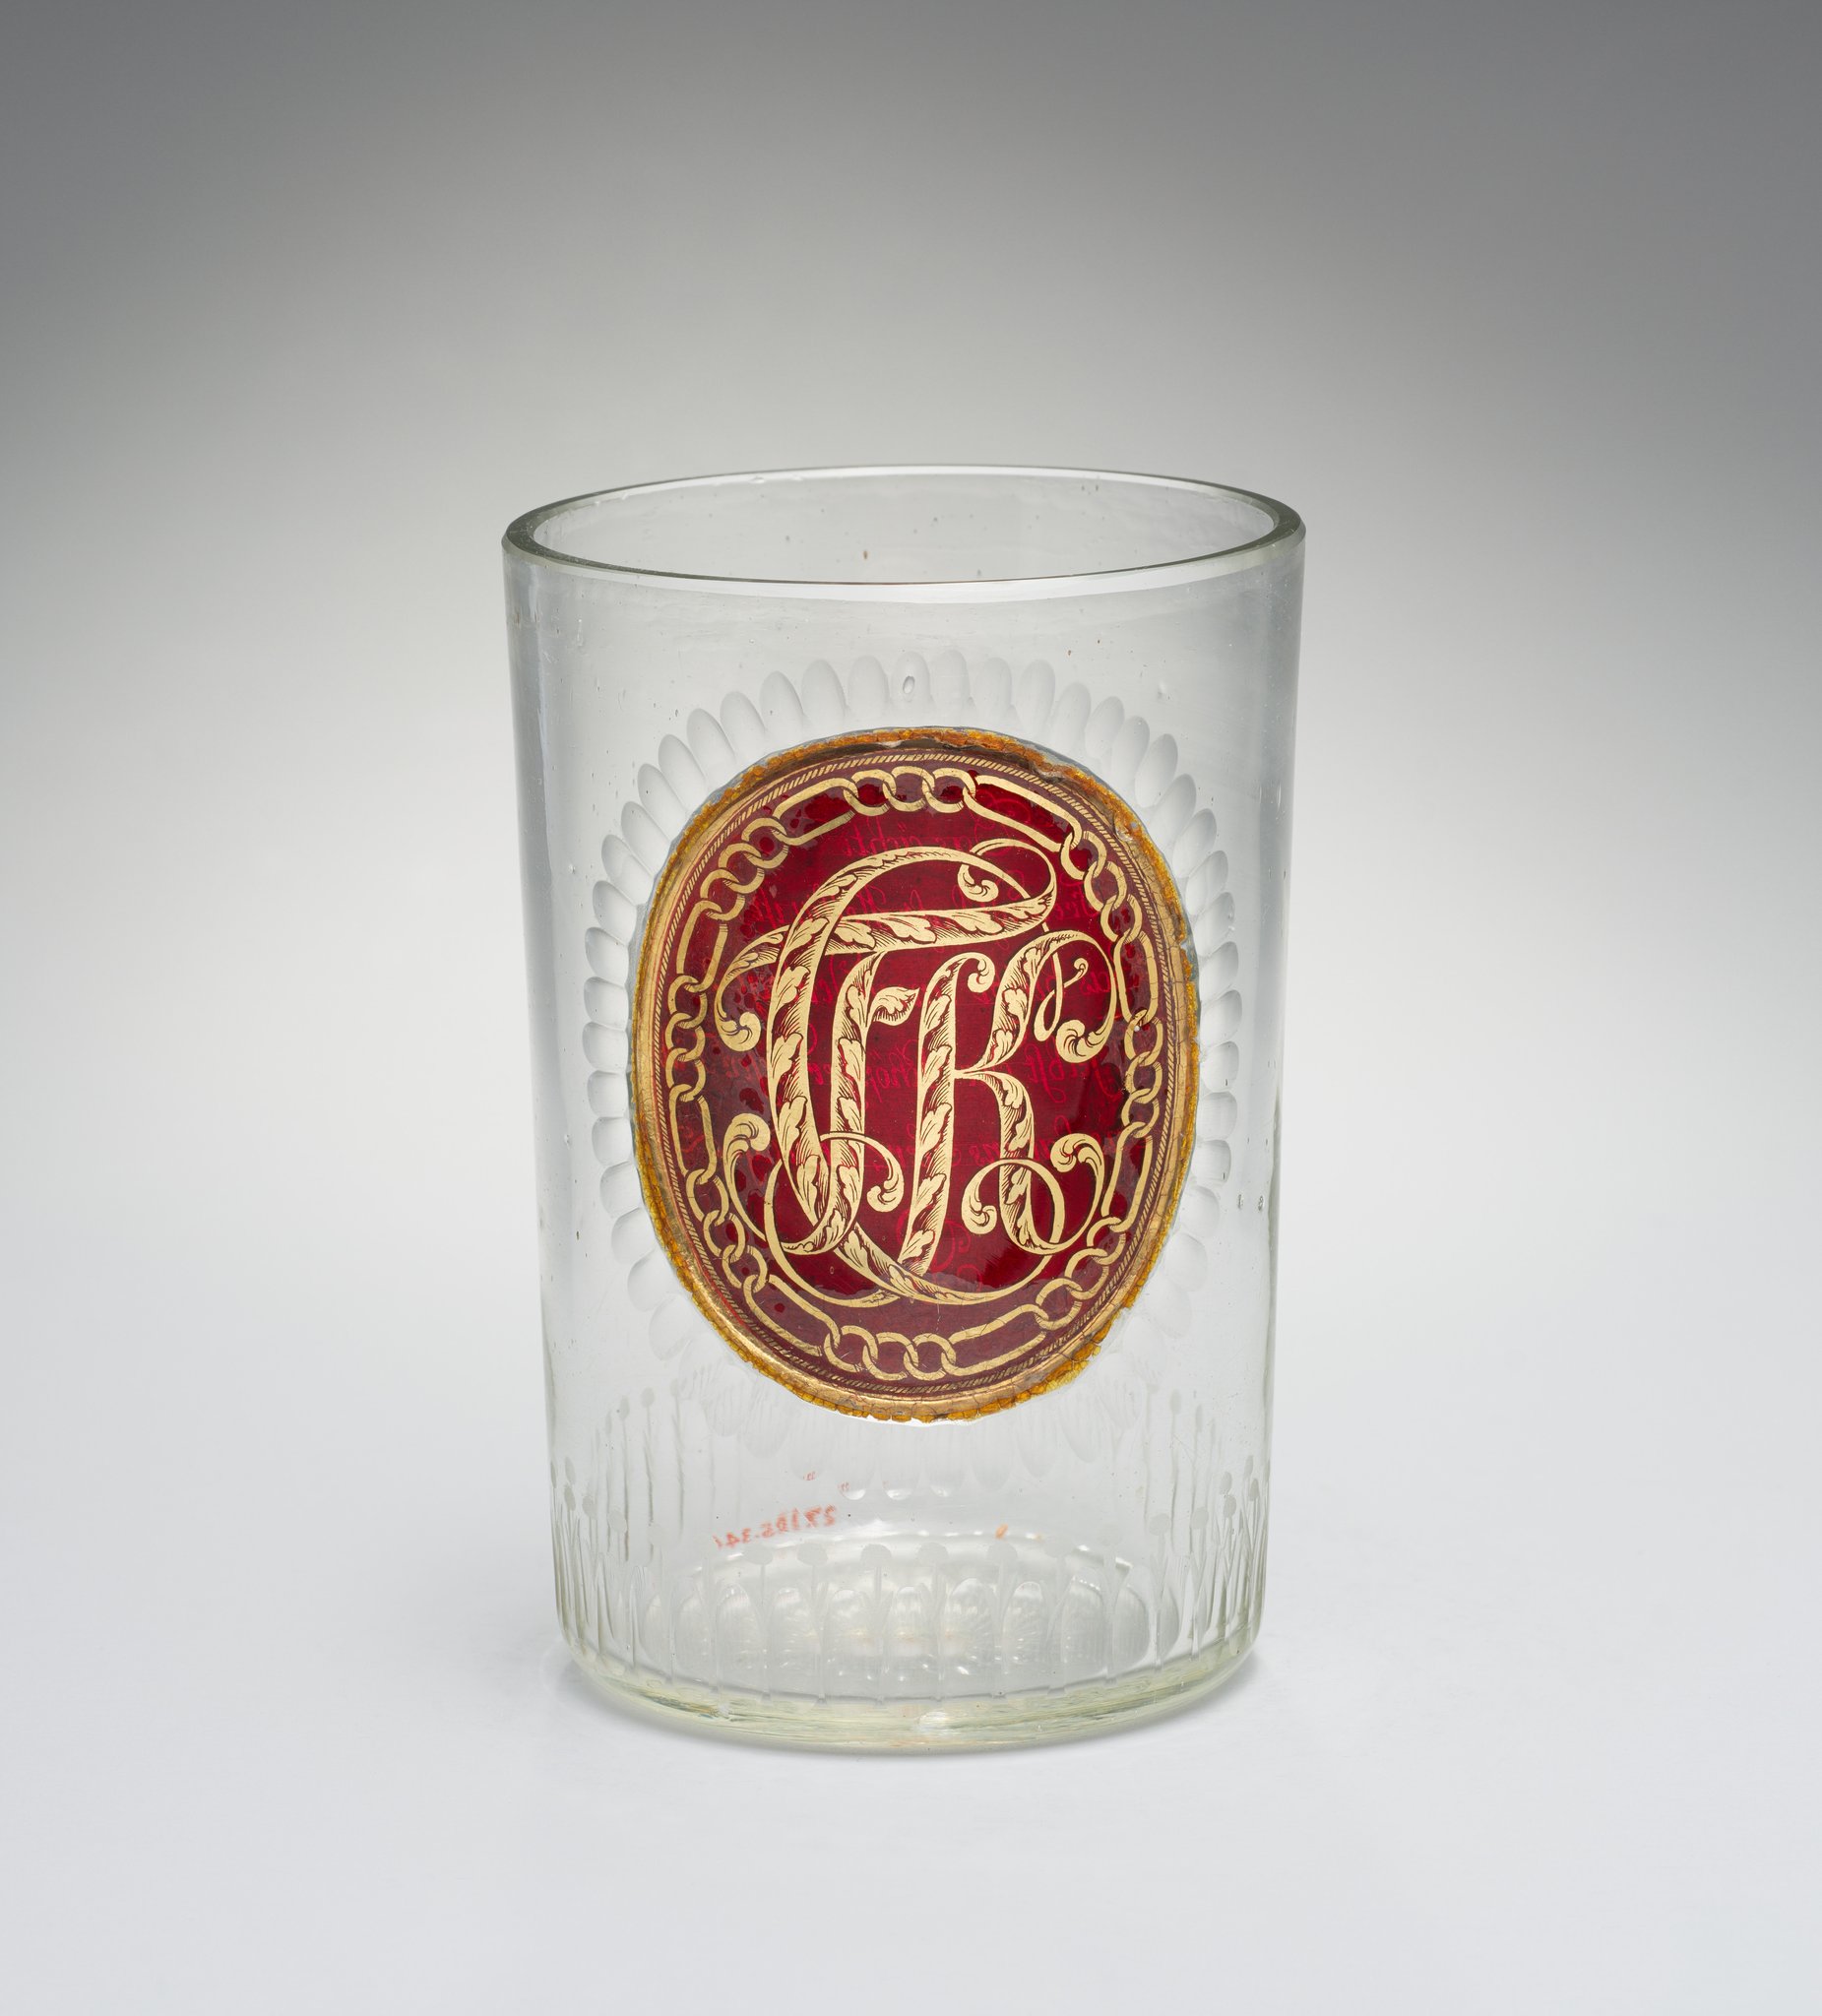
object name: beaker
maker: johann joseph mildner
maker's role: decorator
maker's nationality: austrian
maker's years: 1764-1808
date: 1790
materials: glass